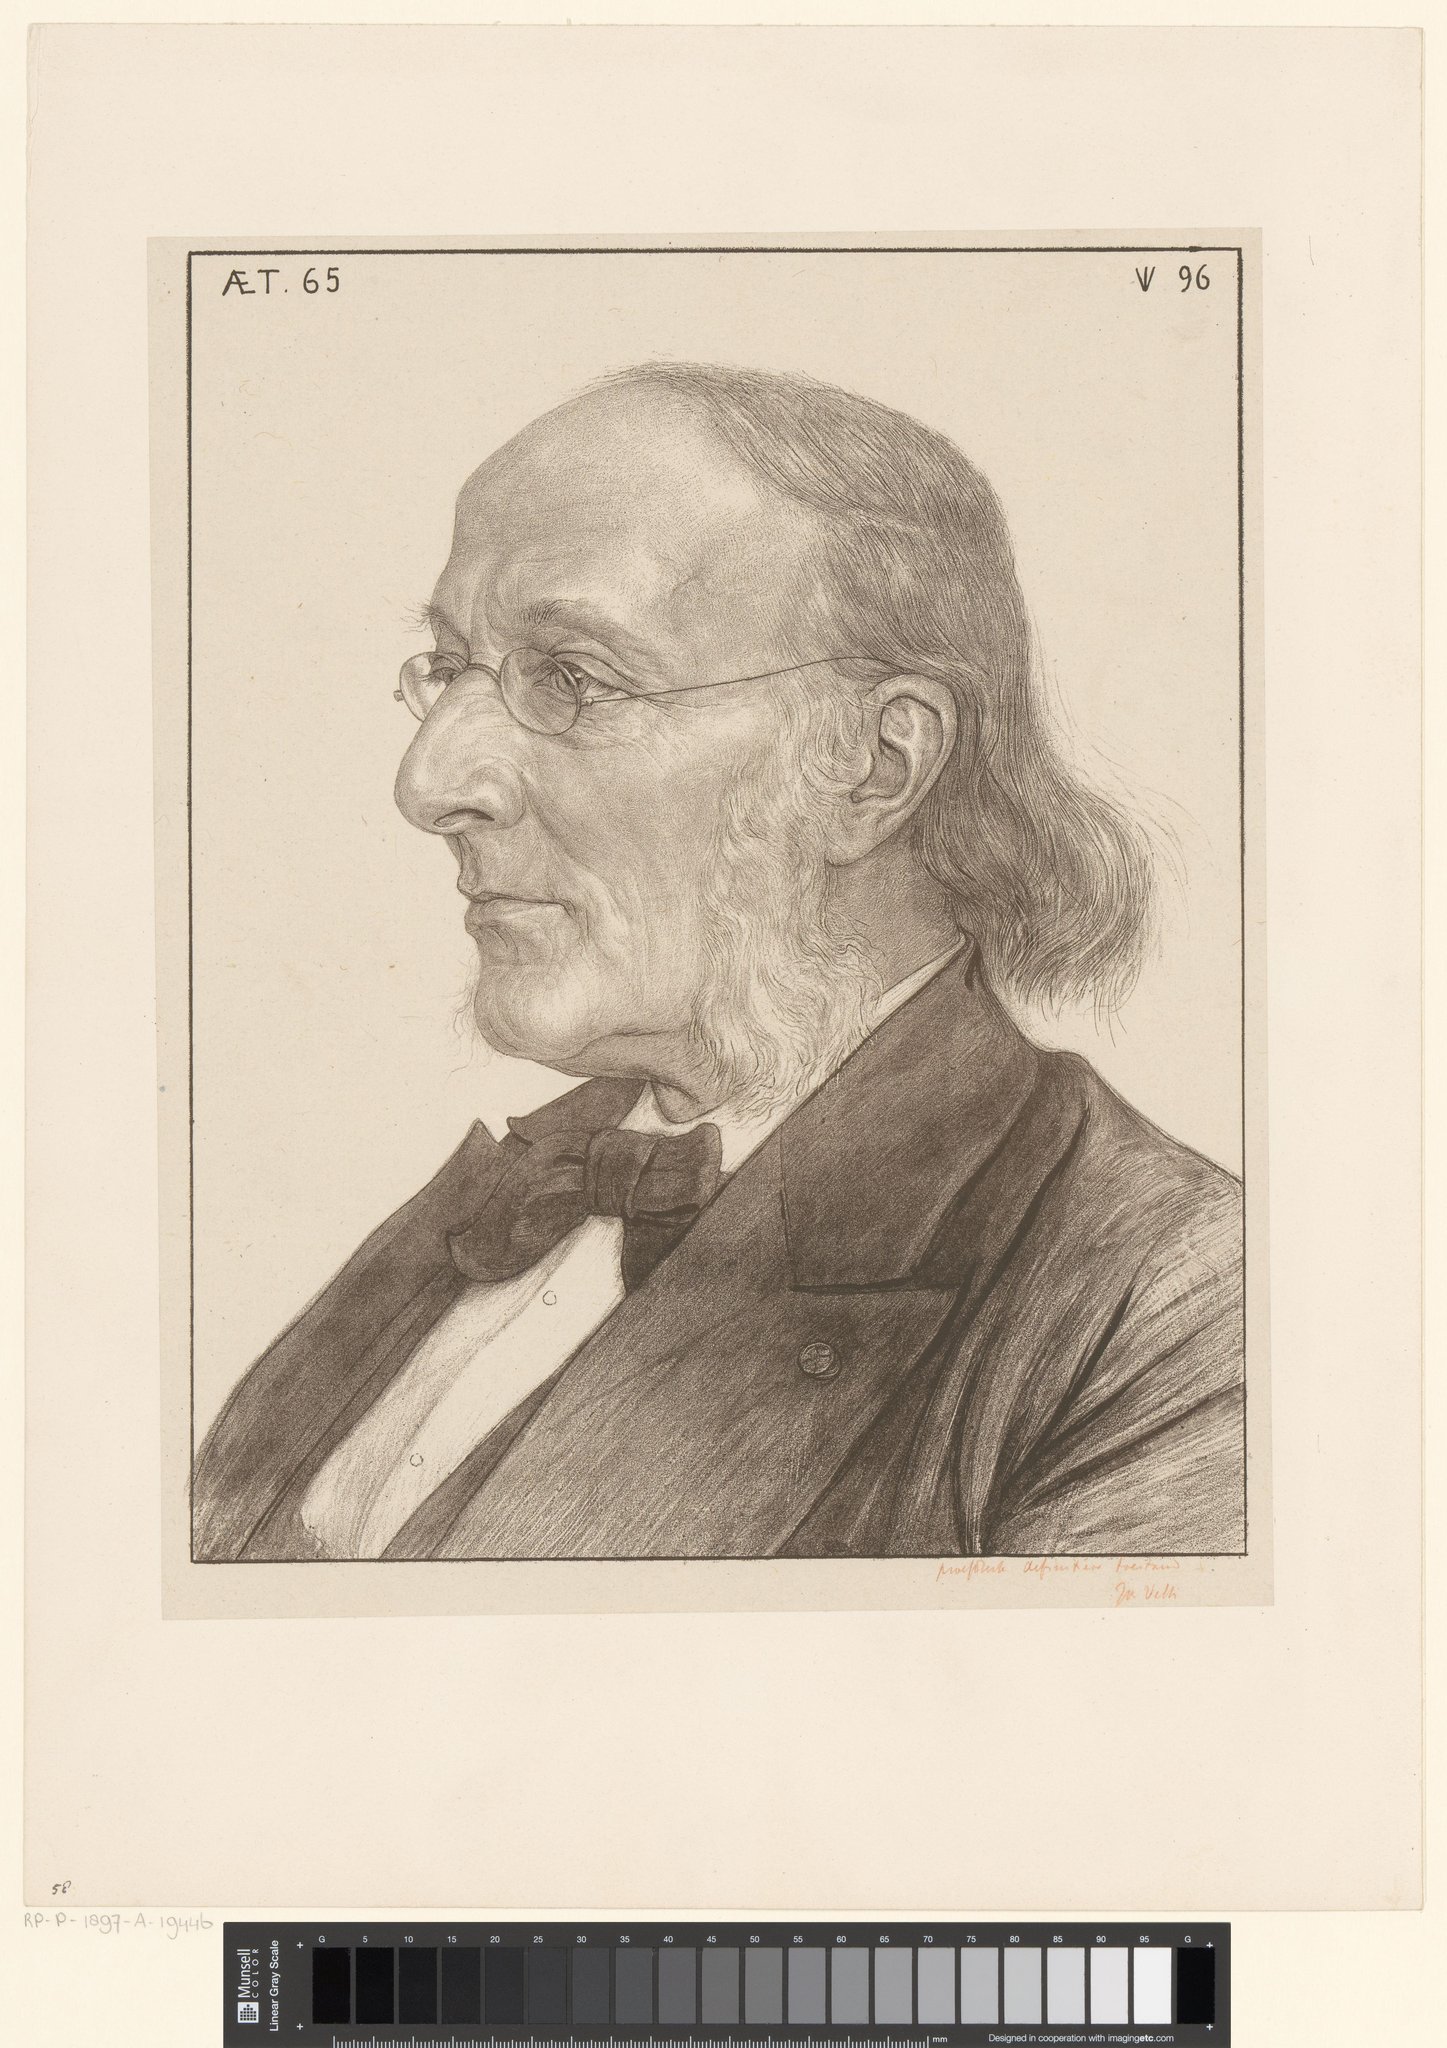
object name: print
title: Portret van Antonie Hendrik Gerrit Paul van den Es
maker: jan veth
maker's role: designer, draughtsman, painter, print maker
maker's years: 1864-1925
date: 1896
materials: paper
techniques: lithograph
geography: netherlands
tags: historical persons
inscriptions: collector's mark: Lugt 2228, inscription: ‘proefdruk definitieve toestand / Jan Veth’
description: Dit portret werd uitgegeven als bijvoegsel bij De Kroniek op 20 december 1896.